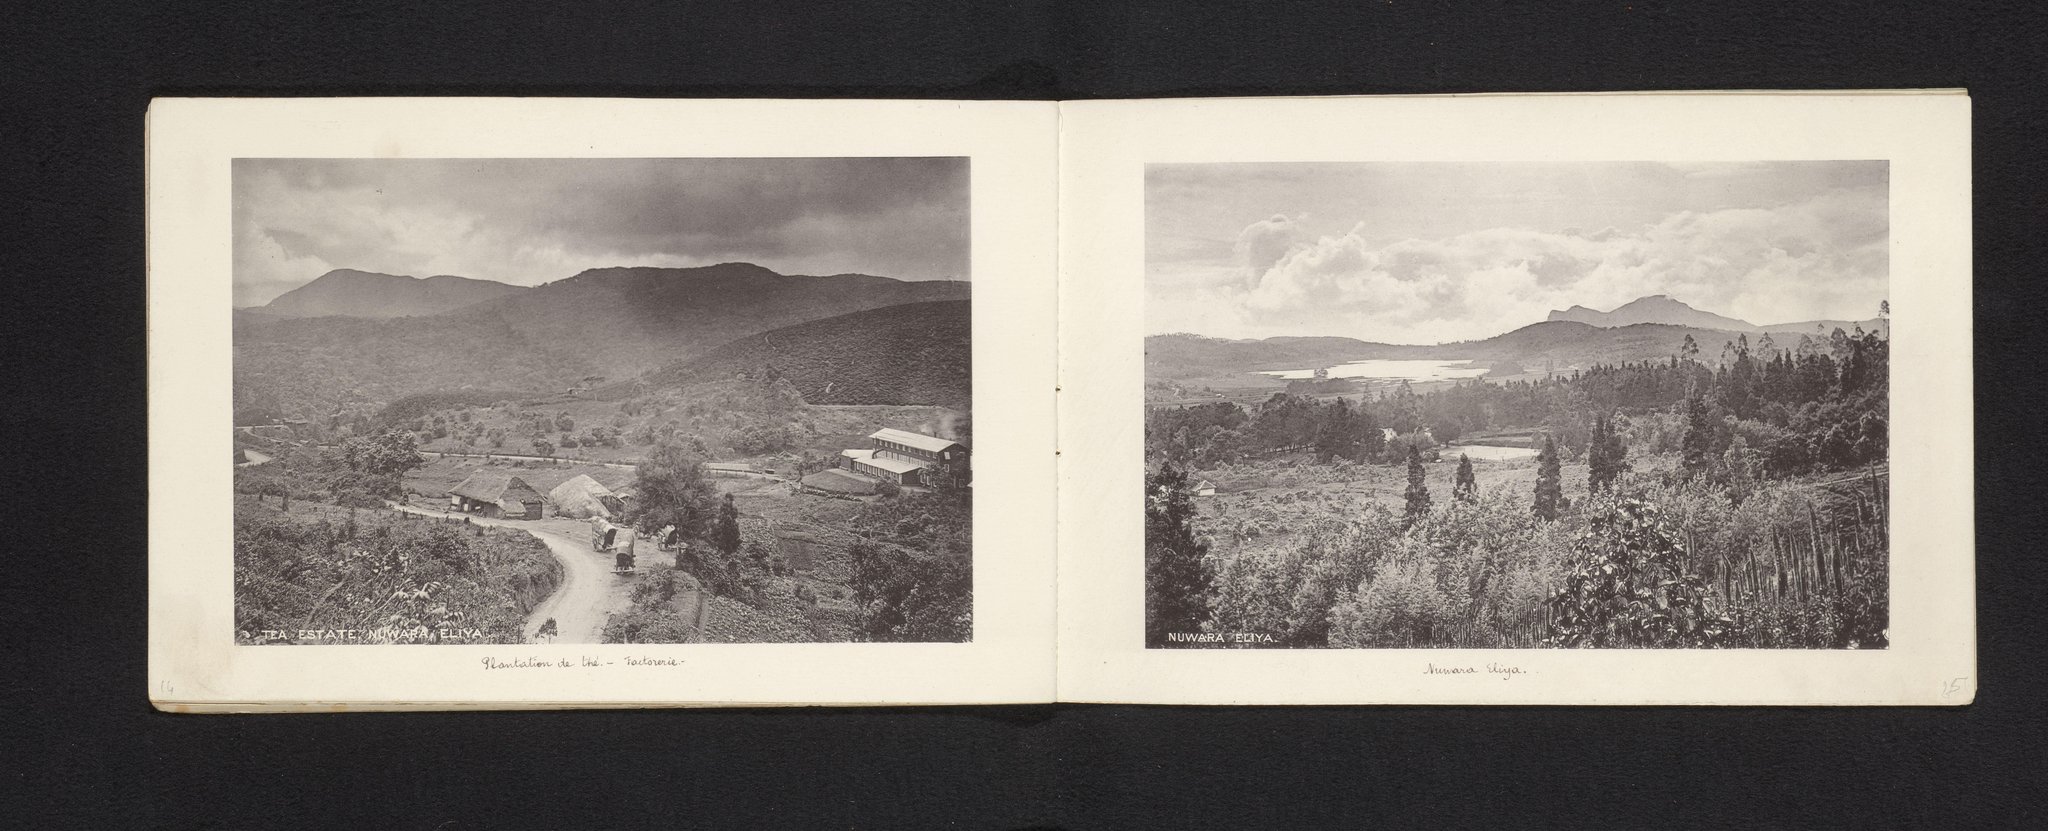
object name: photomechanical print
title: Tea estate, Nuwara Eliya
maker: henry william cave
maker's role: fotograaf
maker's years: 1854-1913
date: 1900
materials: paper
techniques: photograph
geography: nuwara eliya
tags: plantation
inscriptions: inscription: ‘Plantation du thé - Factorerie’